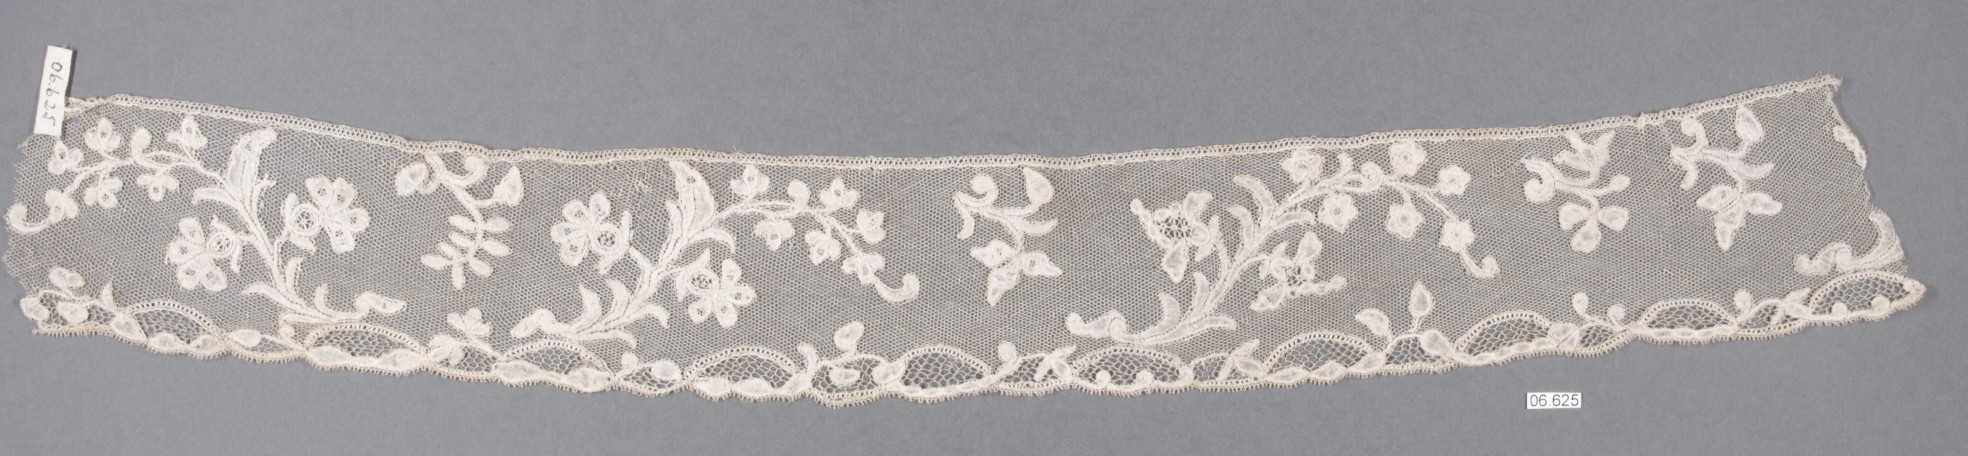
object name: strip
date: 1701-1800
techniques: lace